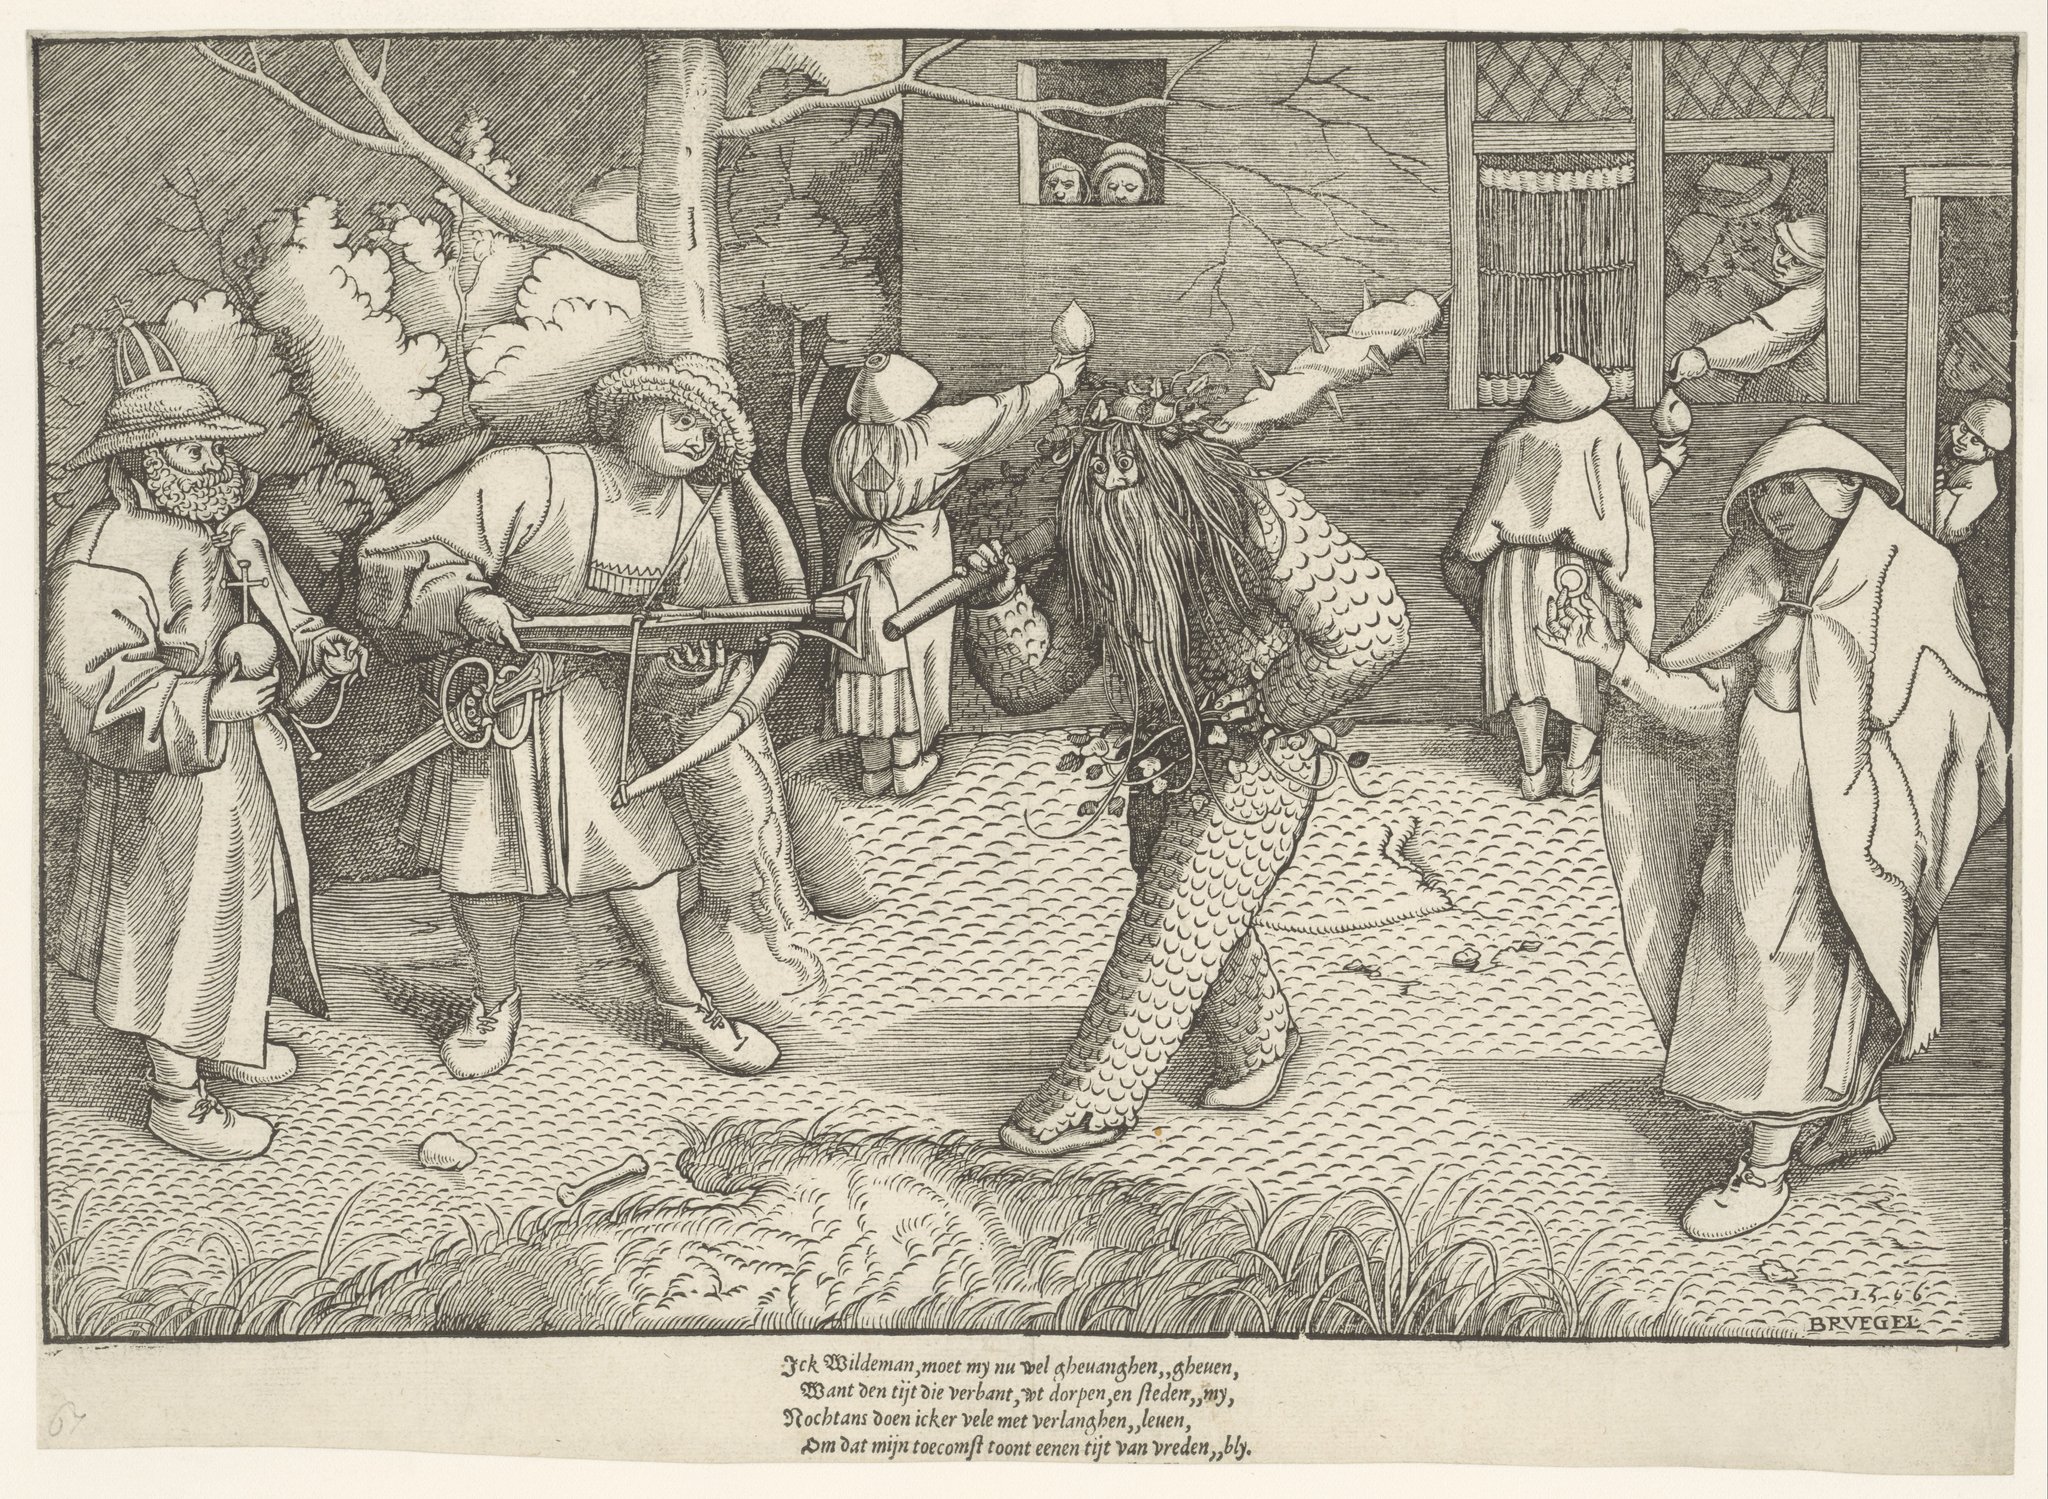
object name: print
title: Maskerade van Ourson en Valentijn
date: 1566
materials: paper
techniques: woodcut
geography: netherlands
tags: theatre, theatrical performance, archer's weapons: crossbow, weapons for striking a blow: club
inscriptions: collector's mark: Lugt 2228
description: De broers Ourson en Valentijn staan tegenover elkaar. Ourson als een wilde met een grote knots en Valentijn dreigend met een kruisboog. Op de achtergrond halen figuren geld op bij buurtbewoners voor het opvoeren van de klucht. In de ondermarge vier regels Nederlandse tekst.